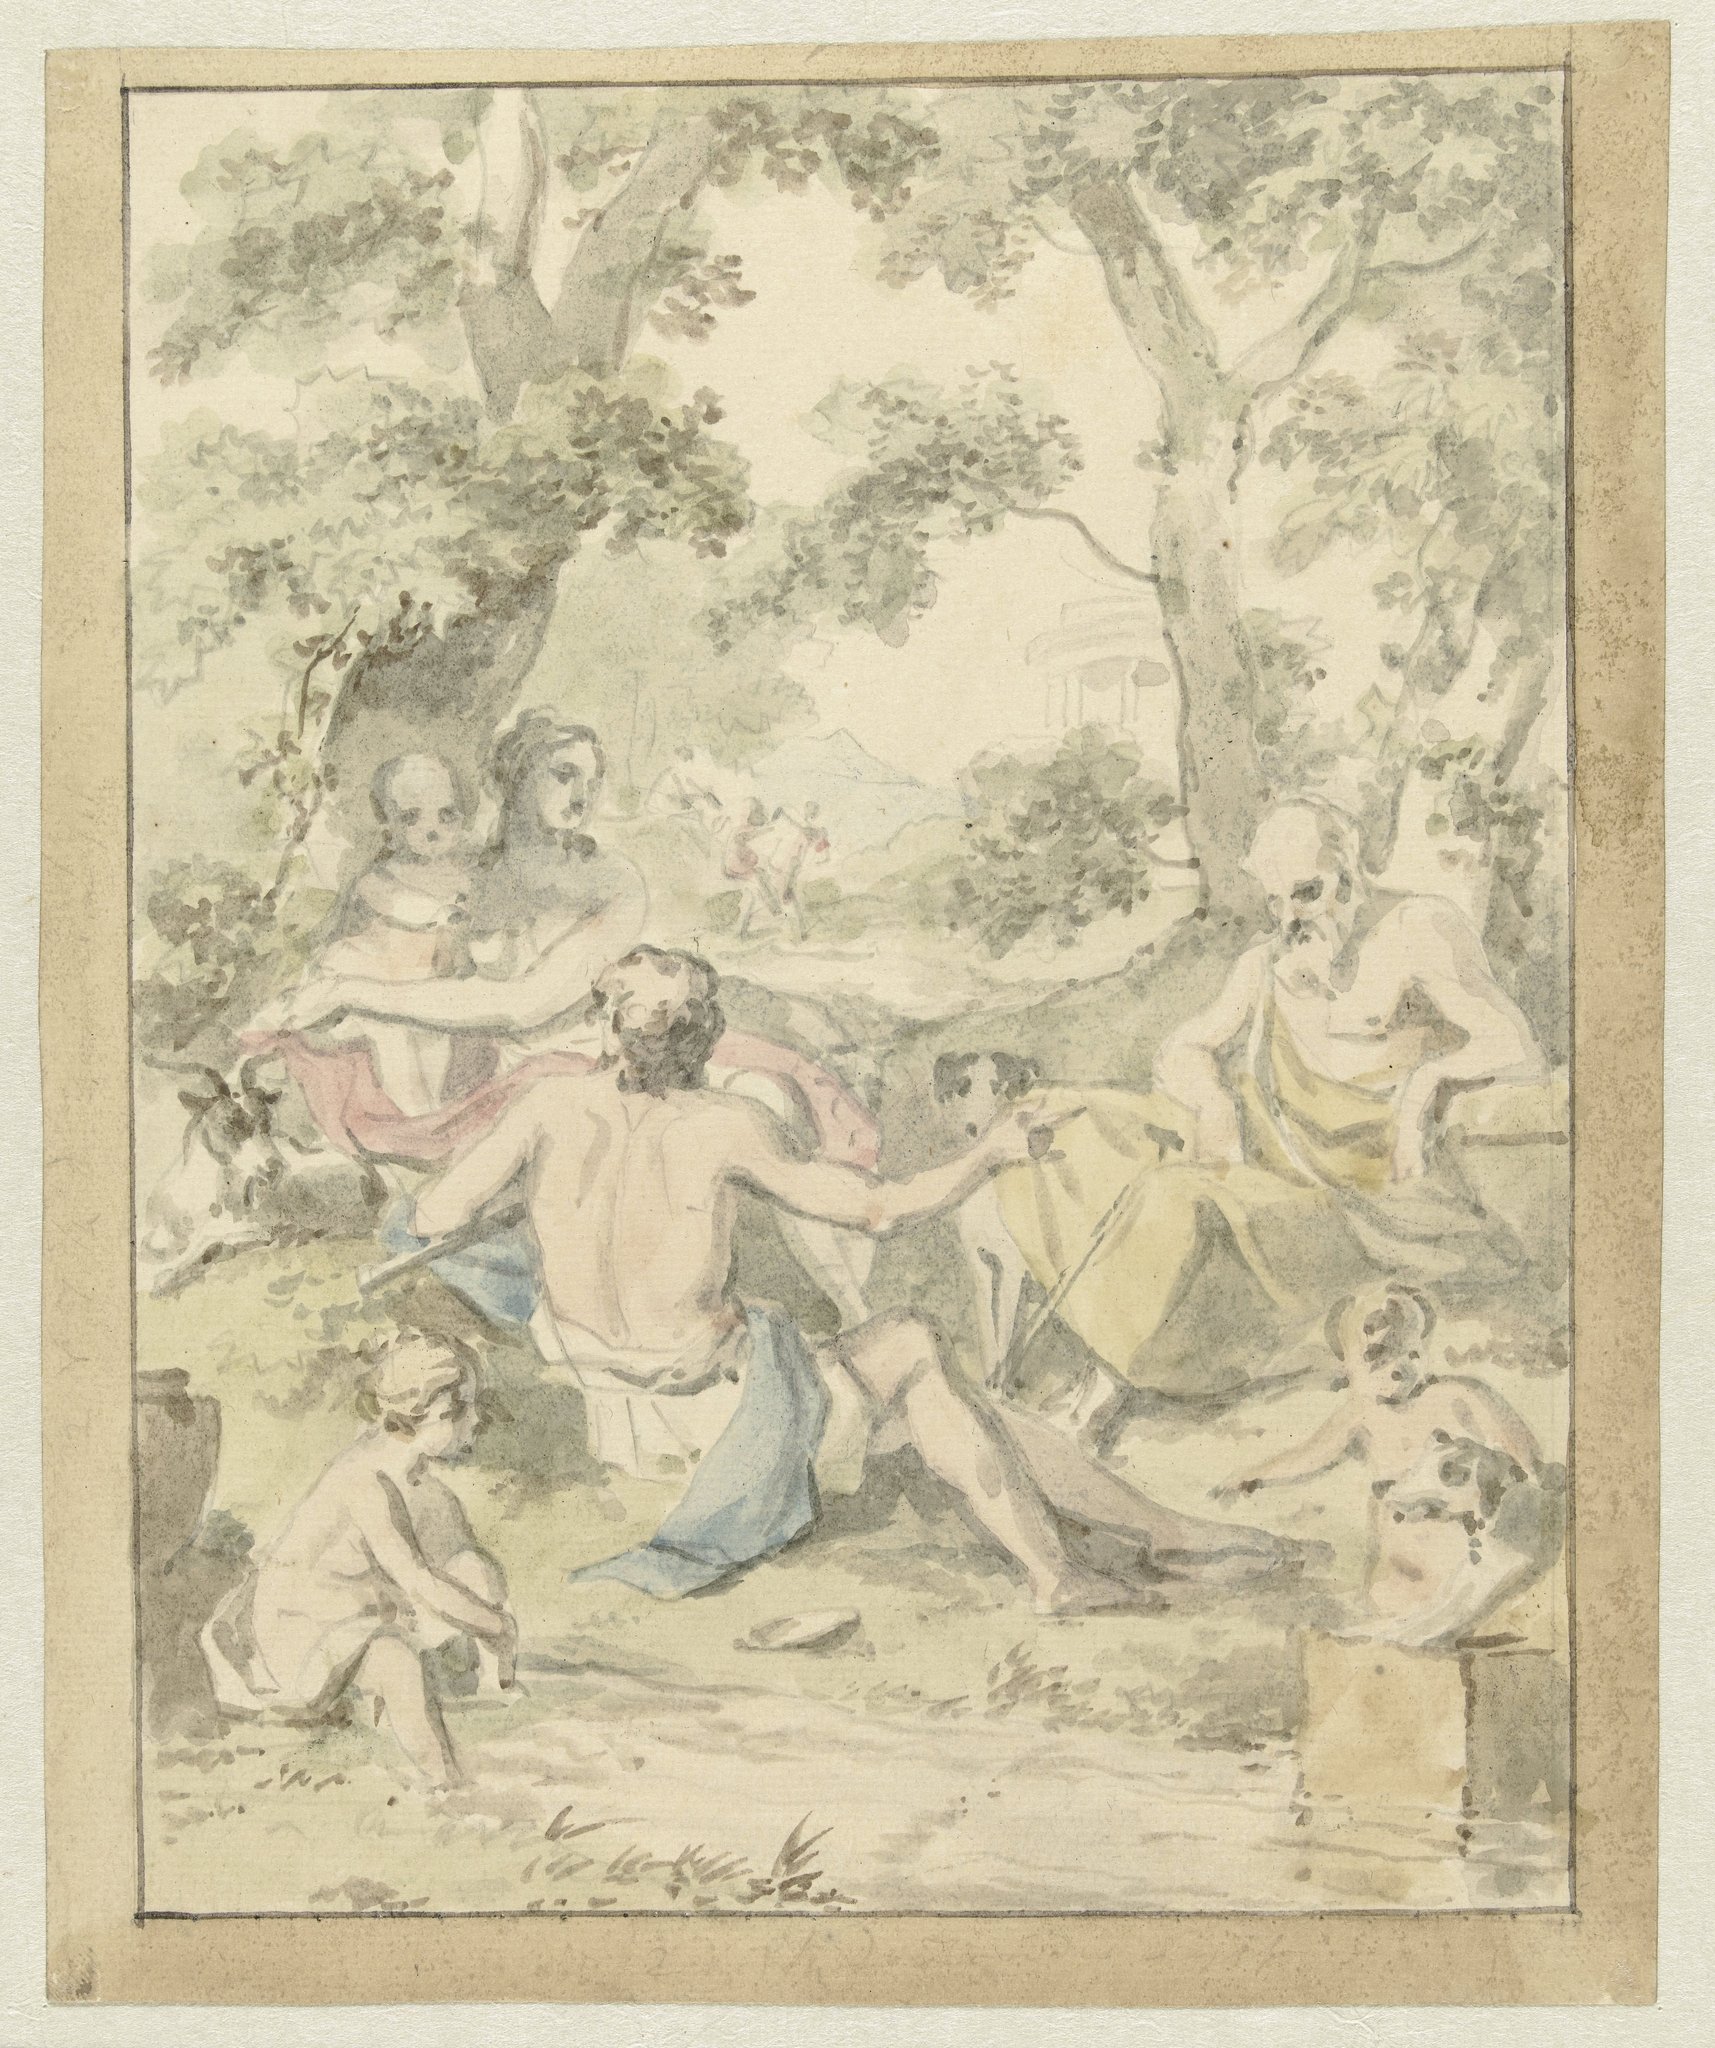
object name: design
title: Een gelukkige Arcadische Familie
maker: jurriaan andriessen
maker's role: draughtsman, painter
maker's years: 1742-1819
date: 1752-1819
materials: graphite, paper, watercolor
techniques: brush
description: Ontwerpschets voor schilderij "Een gelukkige Arcadische Faamielie".